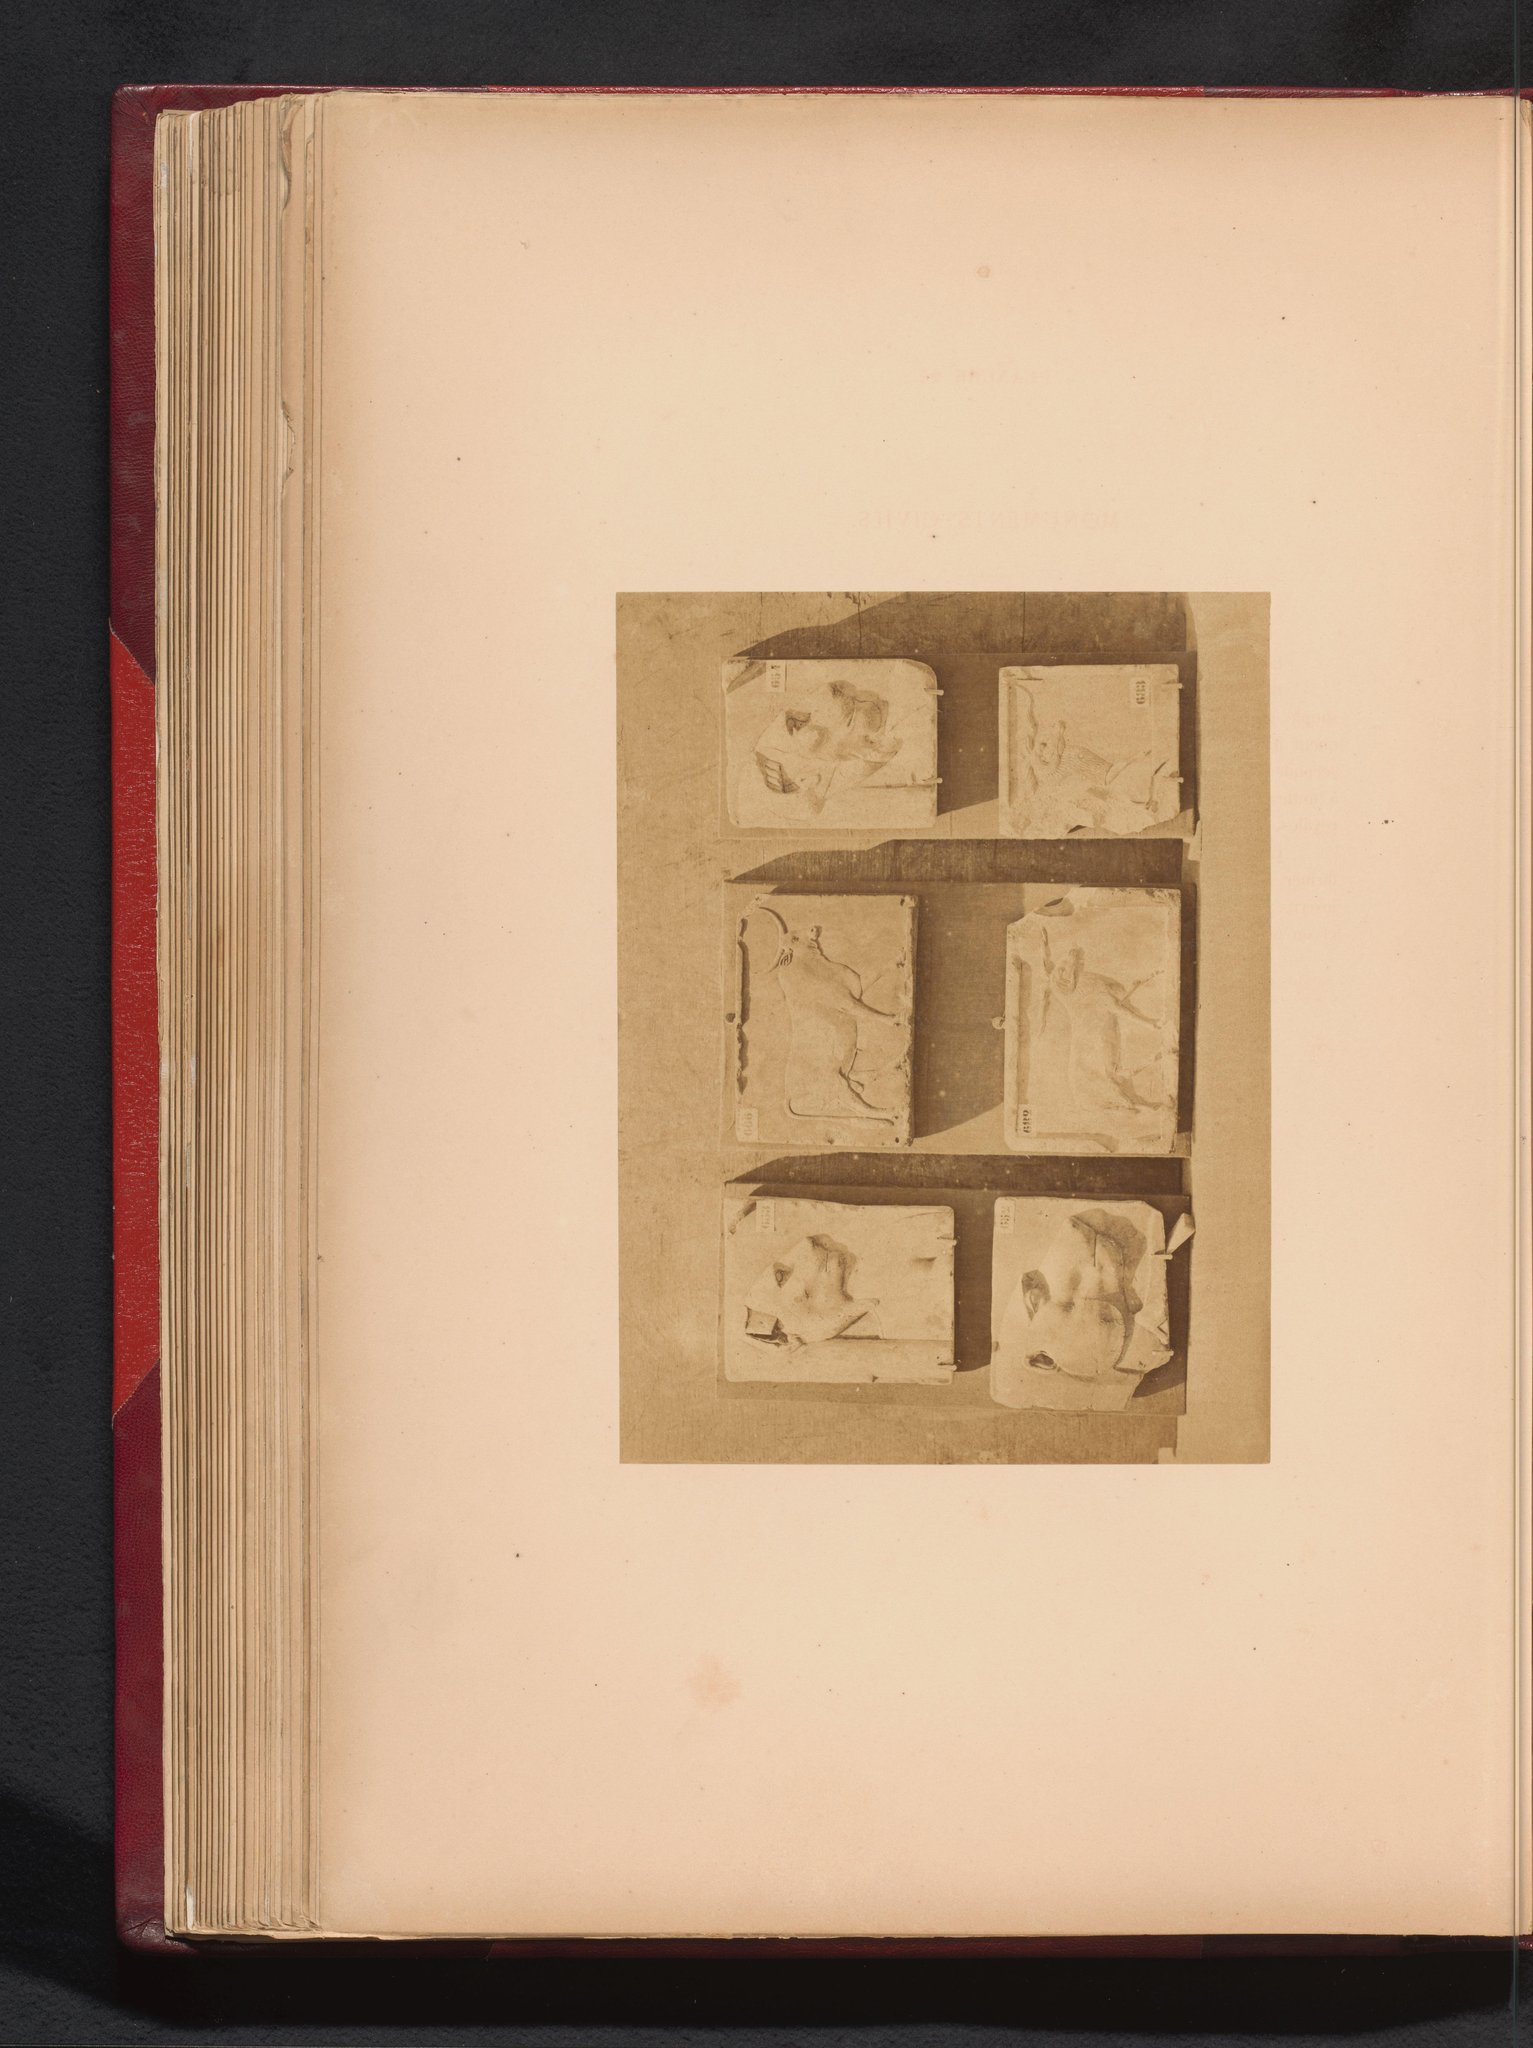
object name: page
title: Zes reliëfs van leeuwen en runderen in het Boulaq Museum in Caïro, Egypte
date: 1866-1871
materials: photographic support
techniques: albumen print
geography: cairo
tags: piece of sculpture, reproduction of a piece of sculpture, permanent exhibition, museum